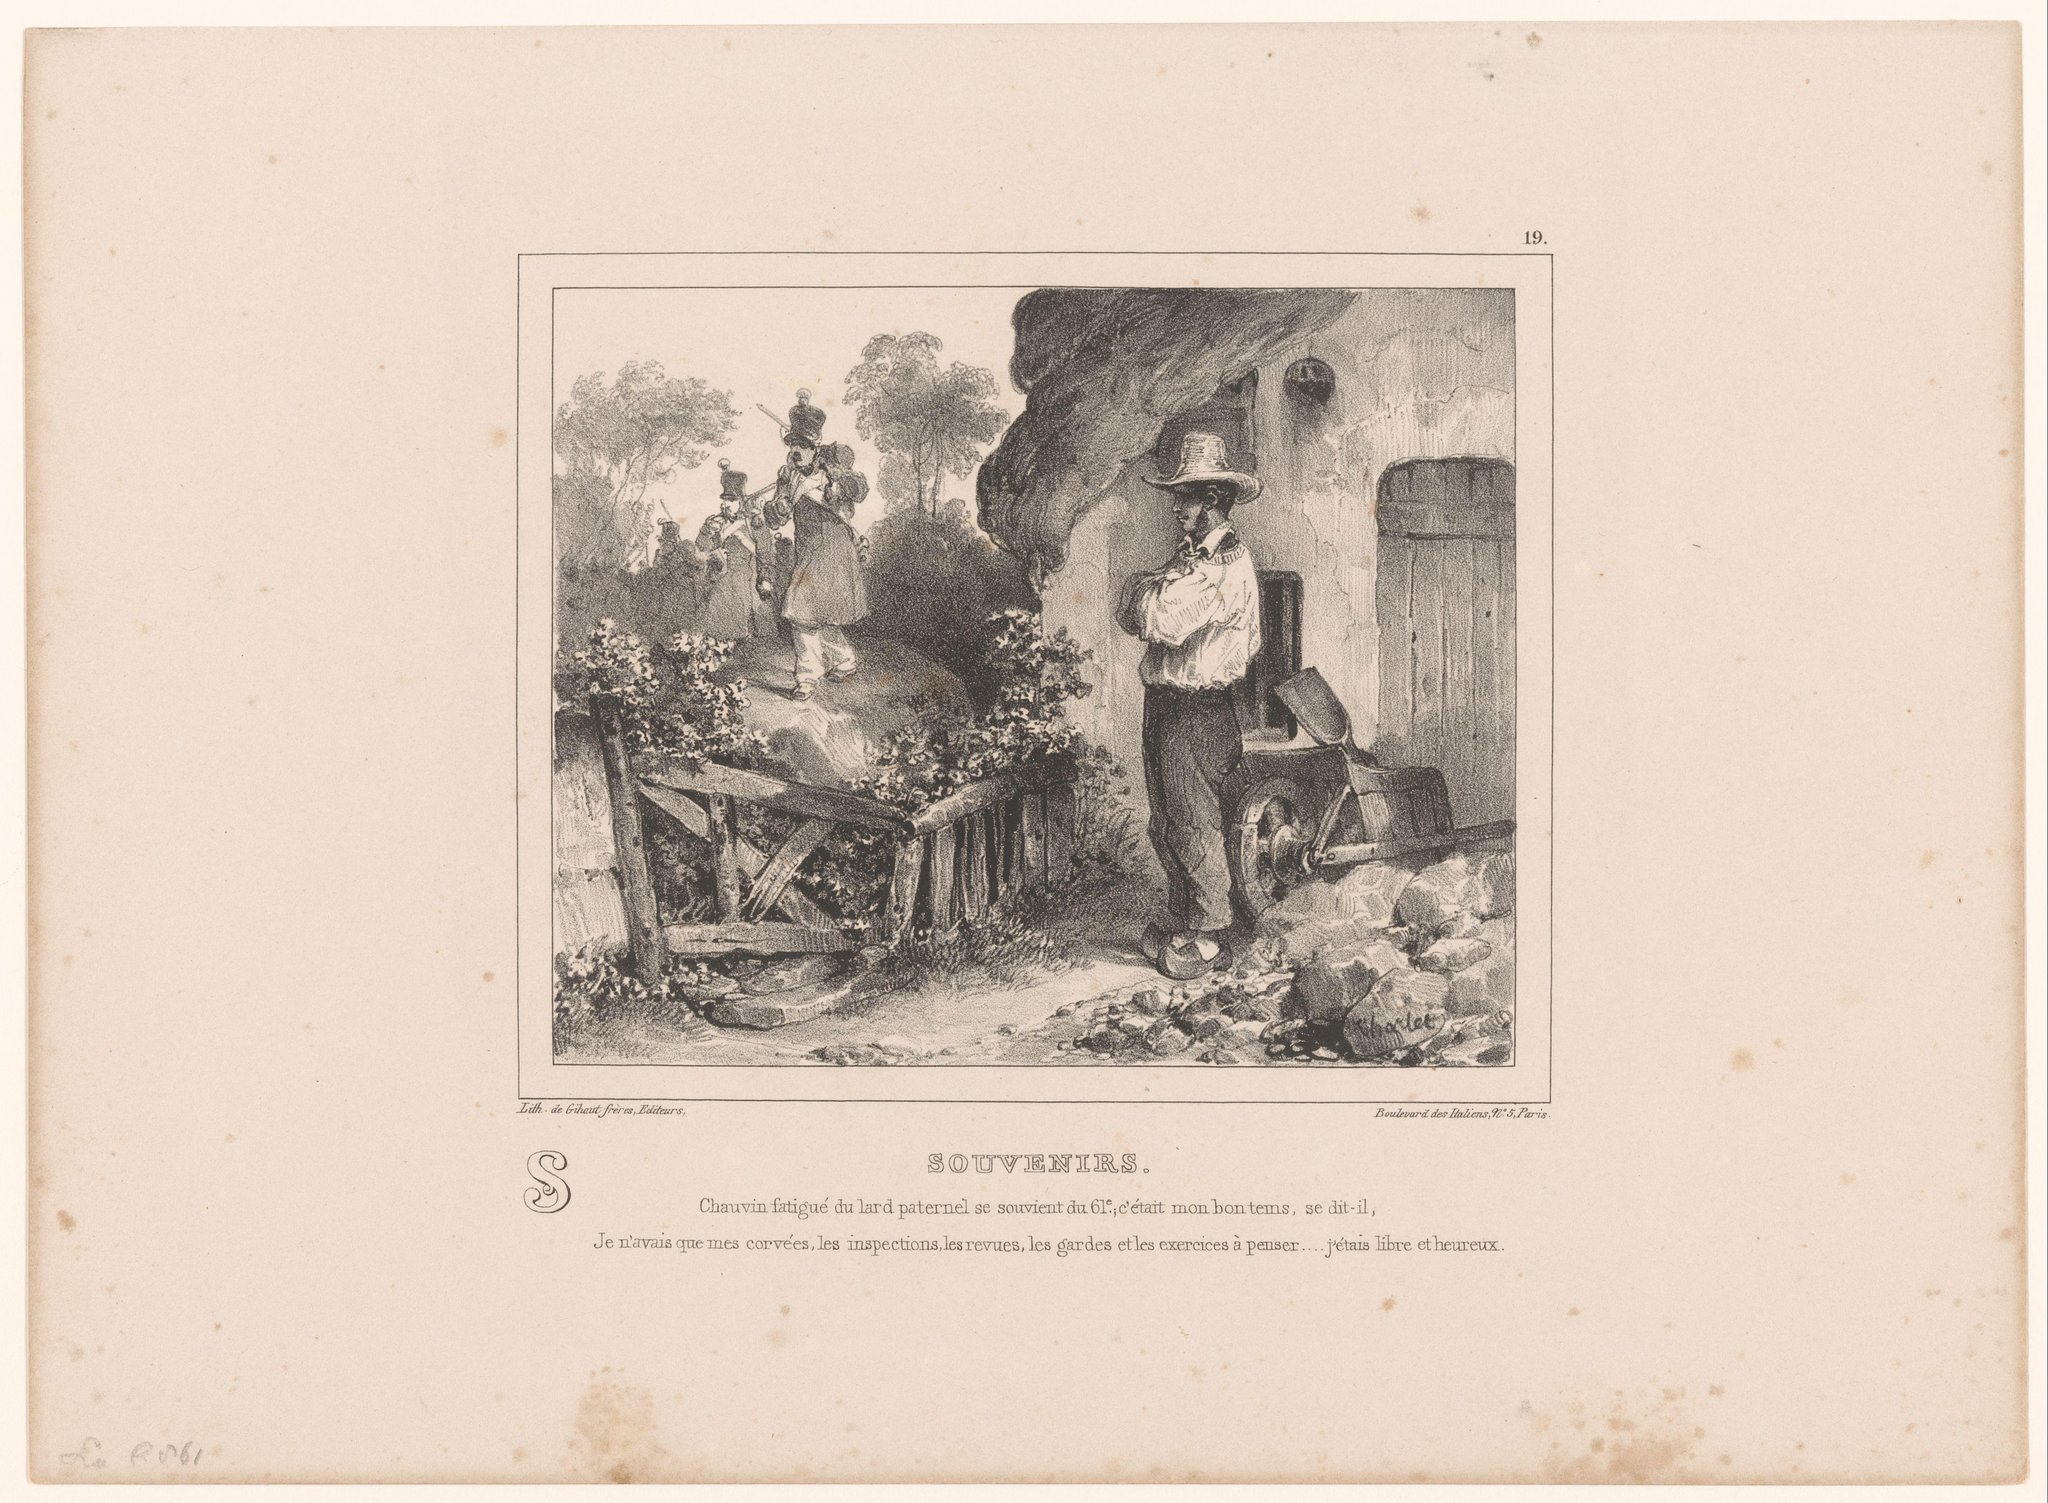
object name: print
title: Alfabet met een moraal voor kinderen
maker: nicolas toussaint charlet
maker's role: draughtsman, painter, print maker, printer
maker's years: 1792-1845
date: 1835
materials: paper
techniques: lithograph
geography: paris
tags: after the completion of service, farm (building)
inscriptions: collector's mark: Lugt 2228a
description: De ex-soldaat Chauvin ziet soldaten passeren langs zijn huis en herinnert zich zijn tijd bij het 61e regiment. Hij beseft dat hij gelukkig was met dat eenvoudige bestaan.